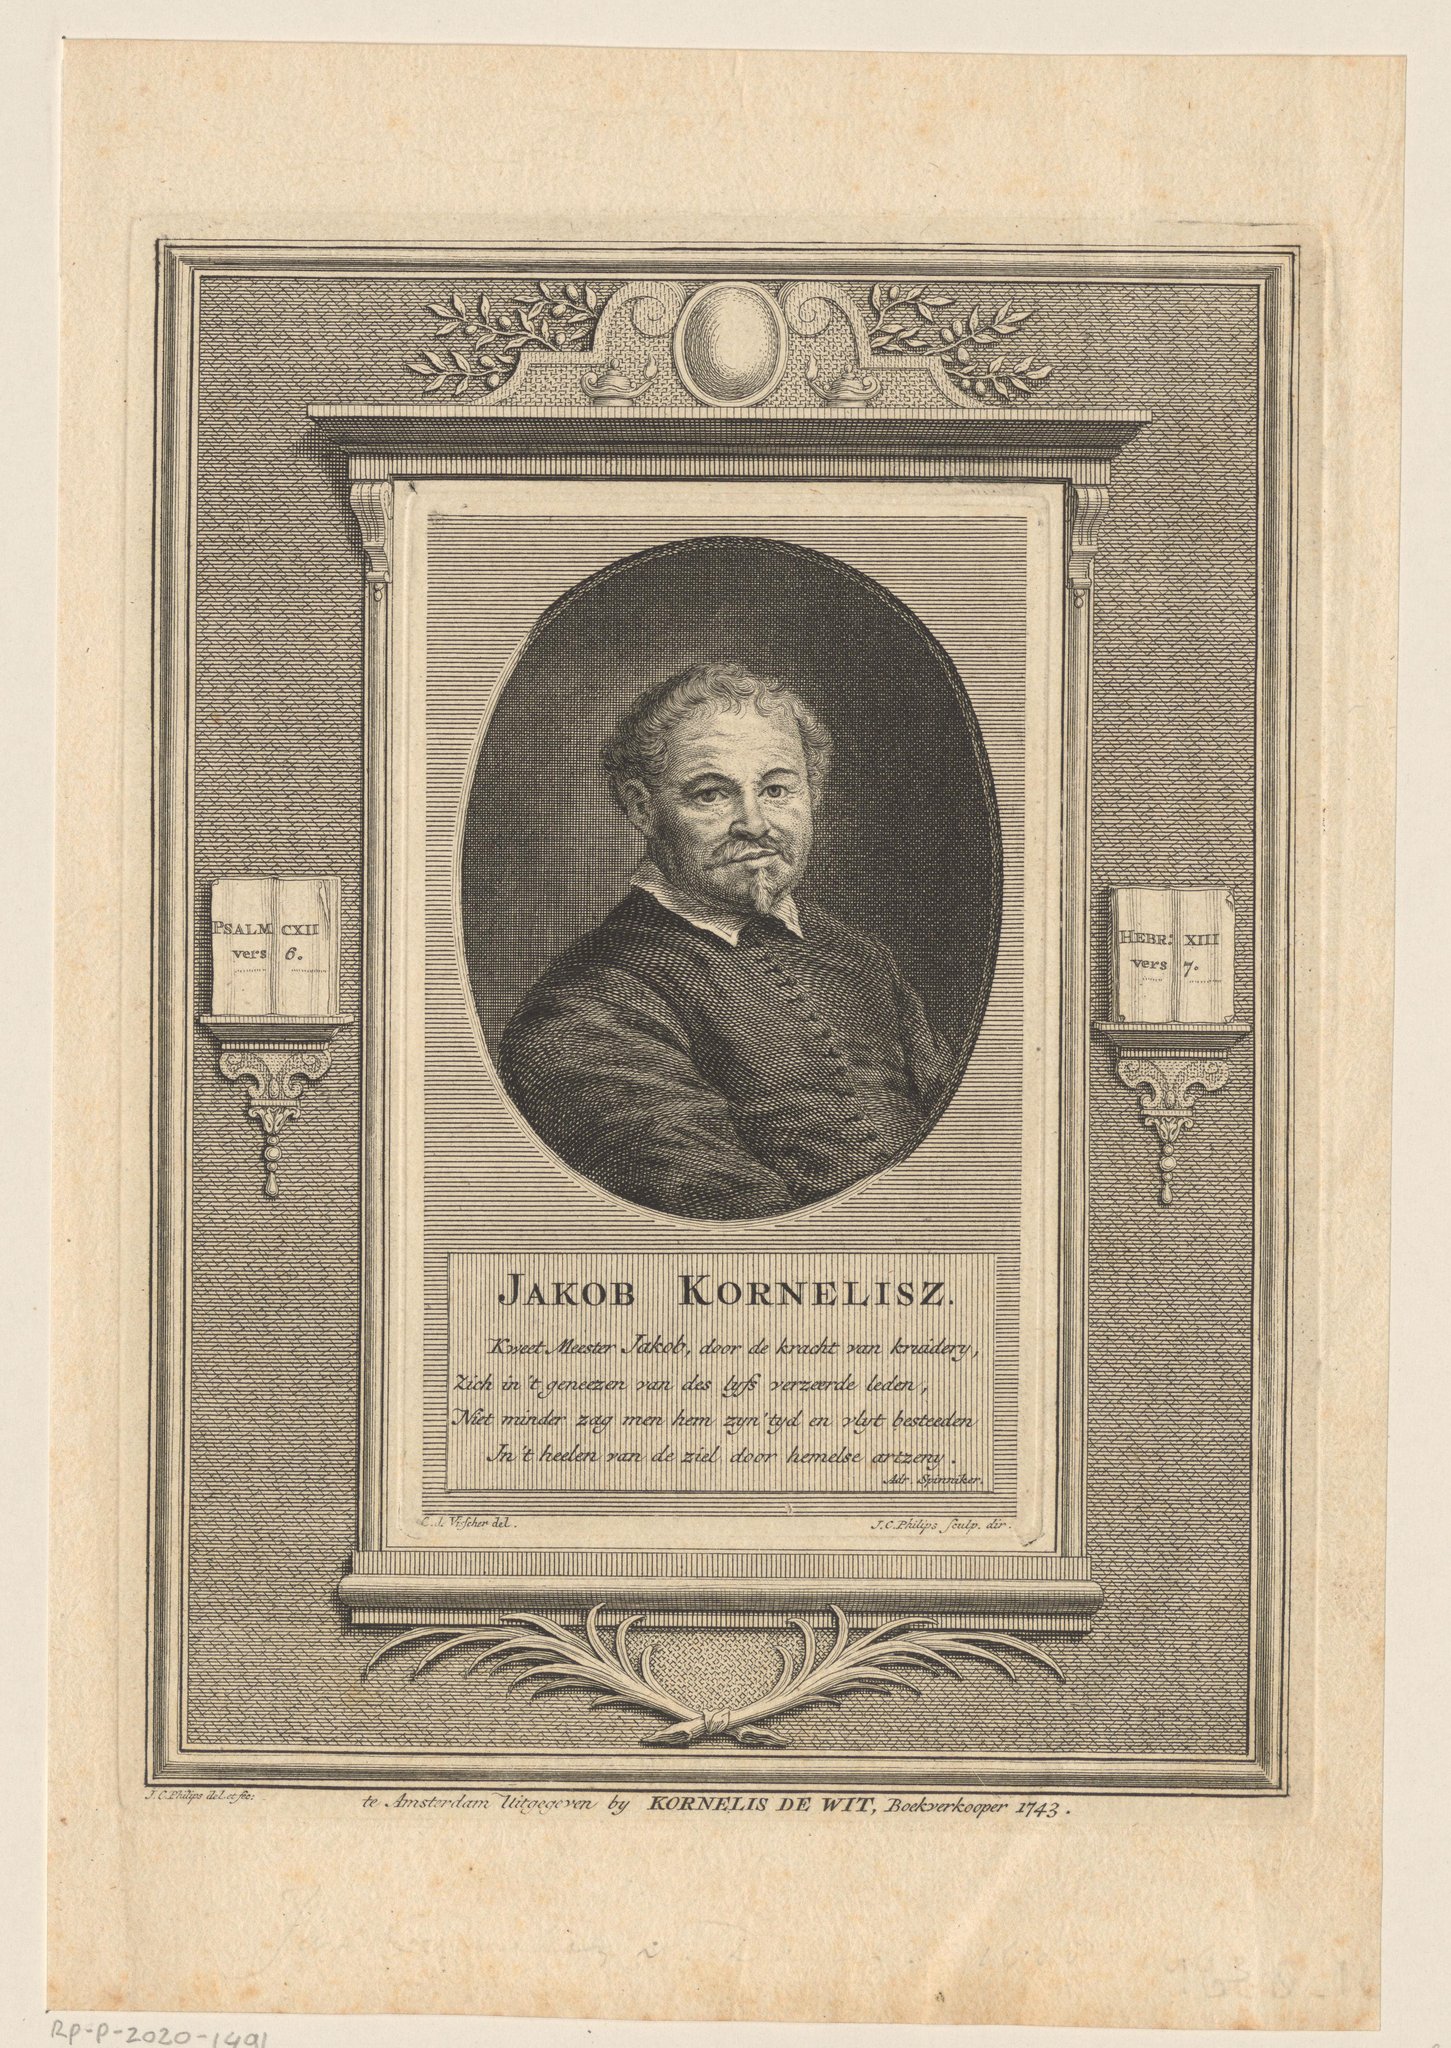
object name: print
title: Portret van Jacob Cornelisz.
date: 1743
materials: paper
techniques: engraving, etching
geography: amsterdam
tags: rotterdam, amsterdam, historical persons, barber; surgeon, organization, functionaries and dignitaries in churches and in related institutions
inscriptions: collector's mark: Lugt 2228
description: Prent is gedrukt met twee platen, bestaande uit het portret en de omlijsting. De kleinste plaat met het portret is ook apart verschenen. Zie ook RP-P-1907-3292.